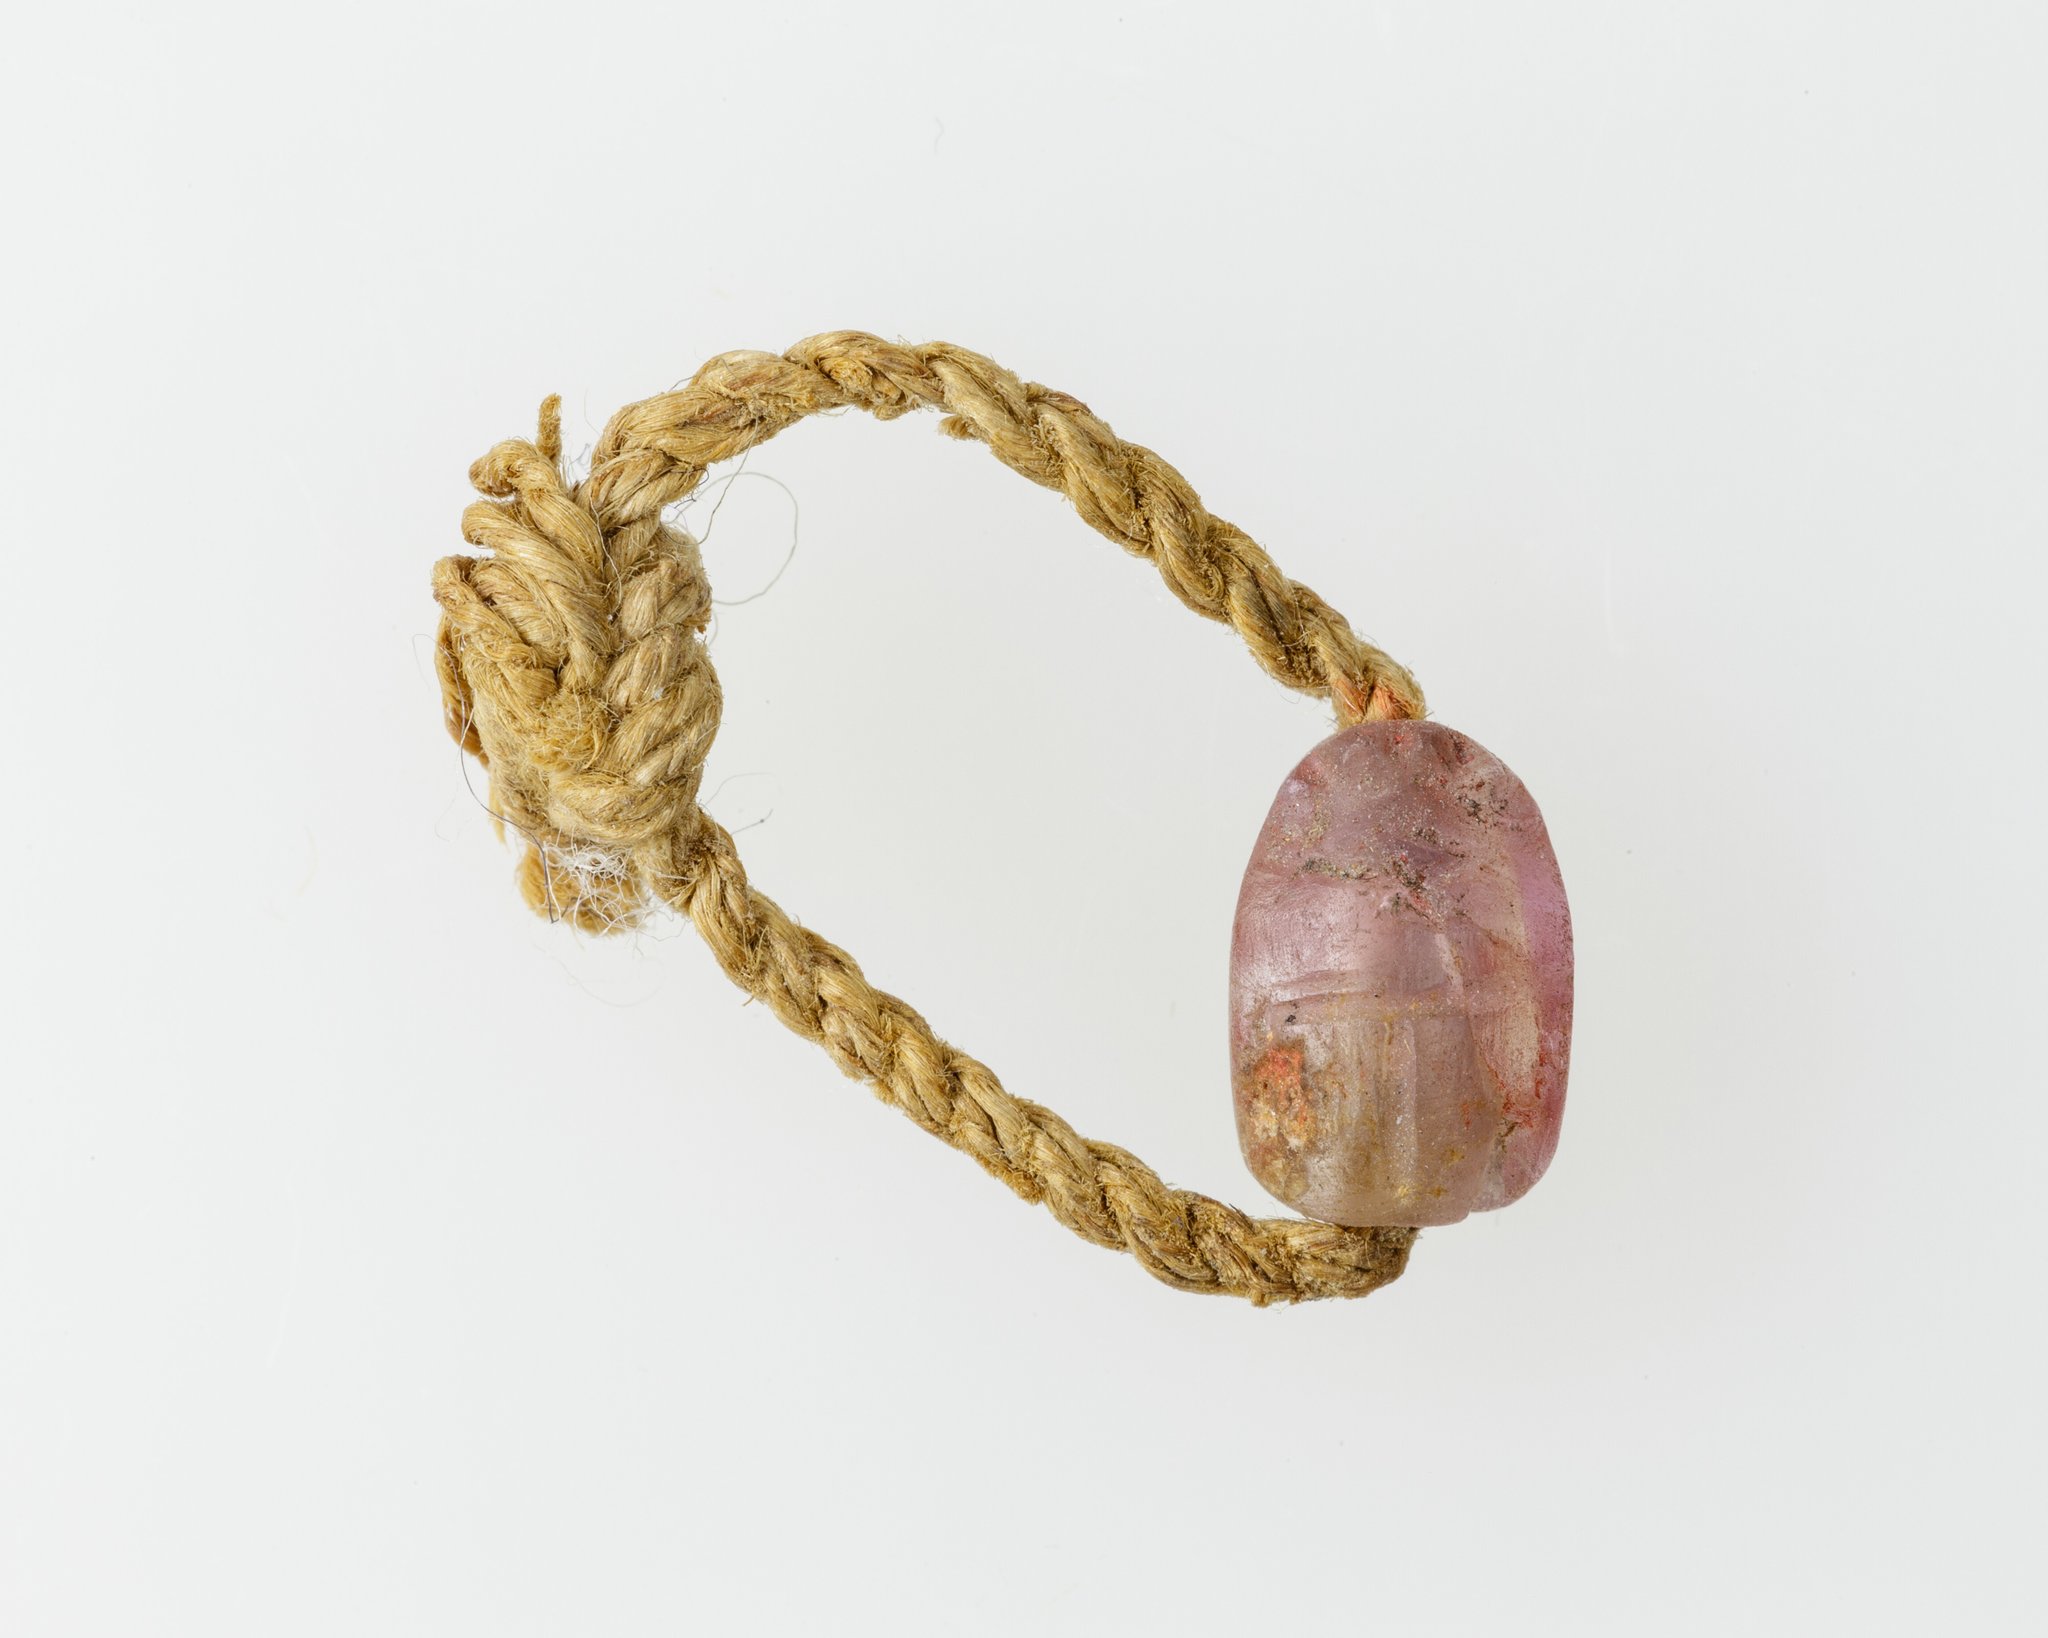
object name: ring with scarab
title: Scarab ring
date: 1750-1700 BCE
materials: gemstone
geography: egypt